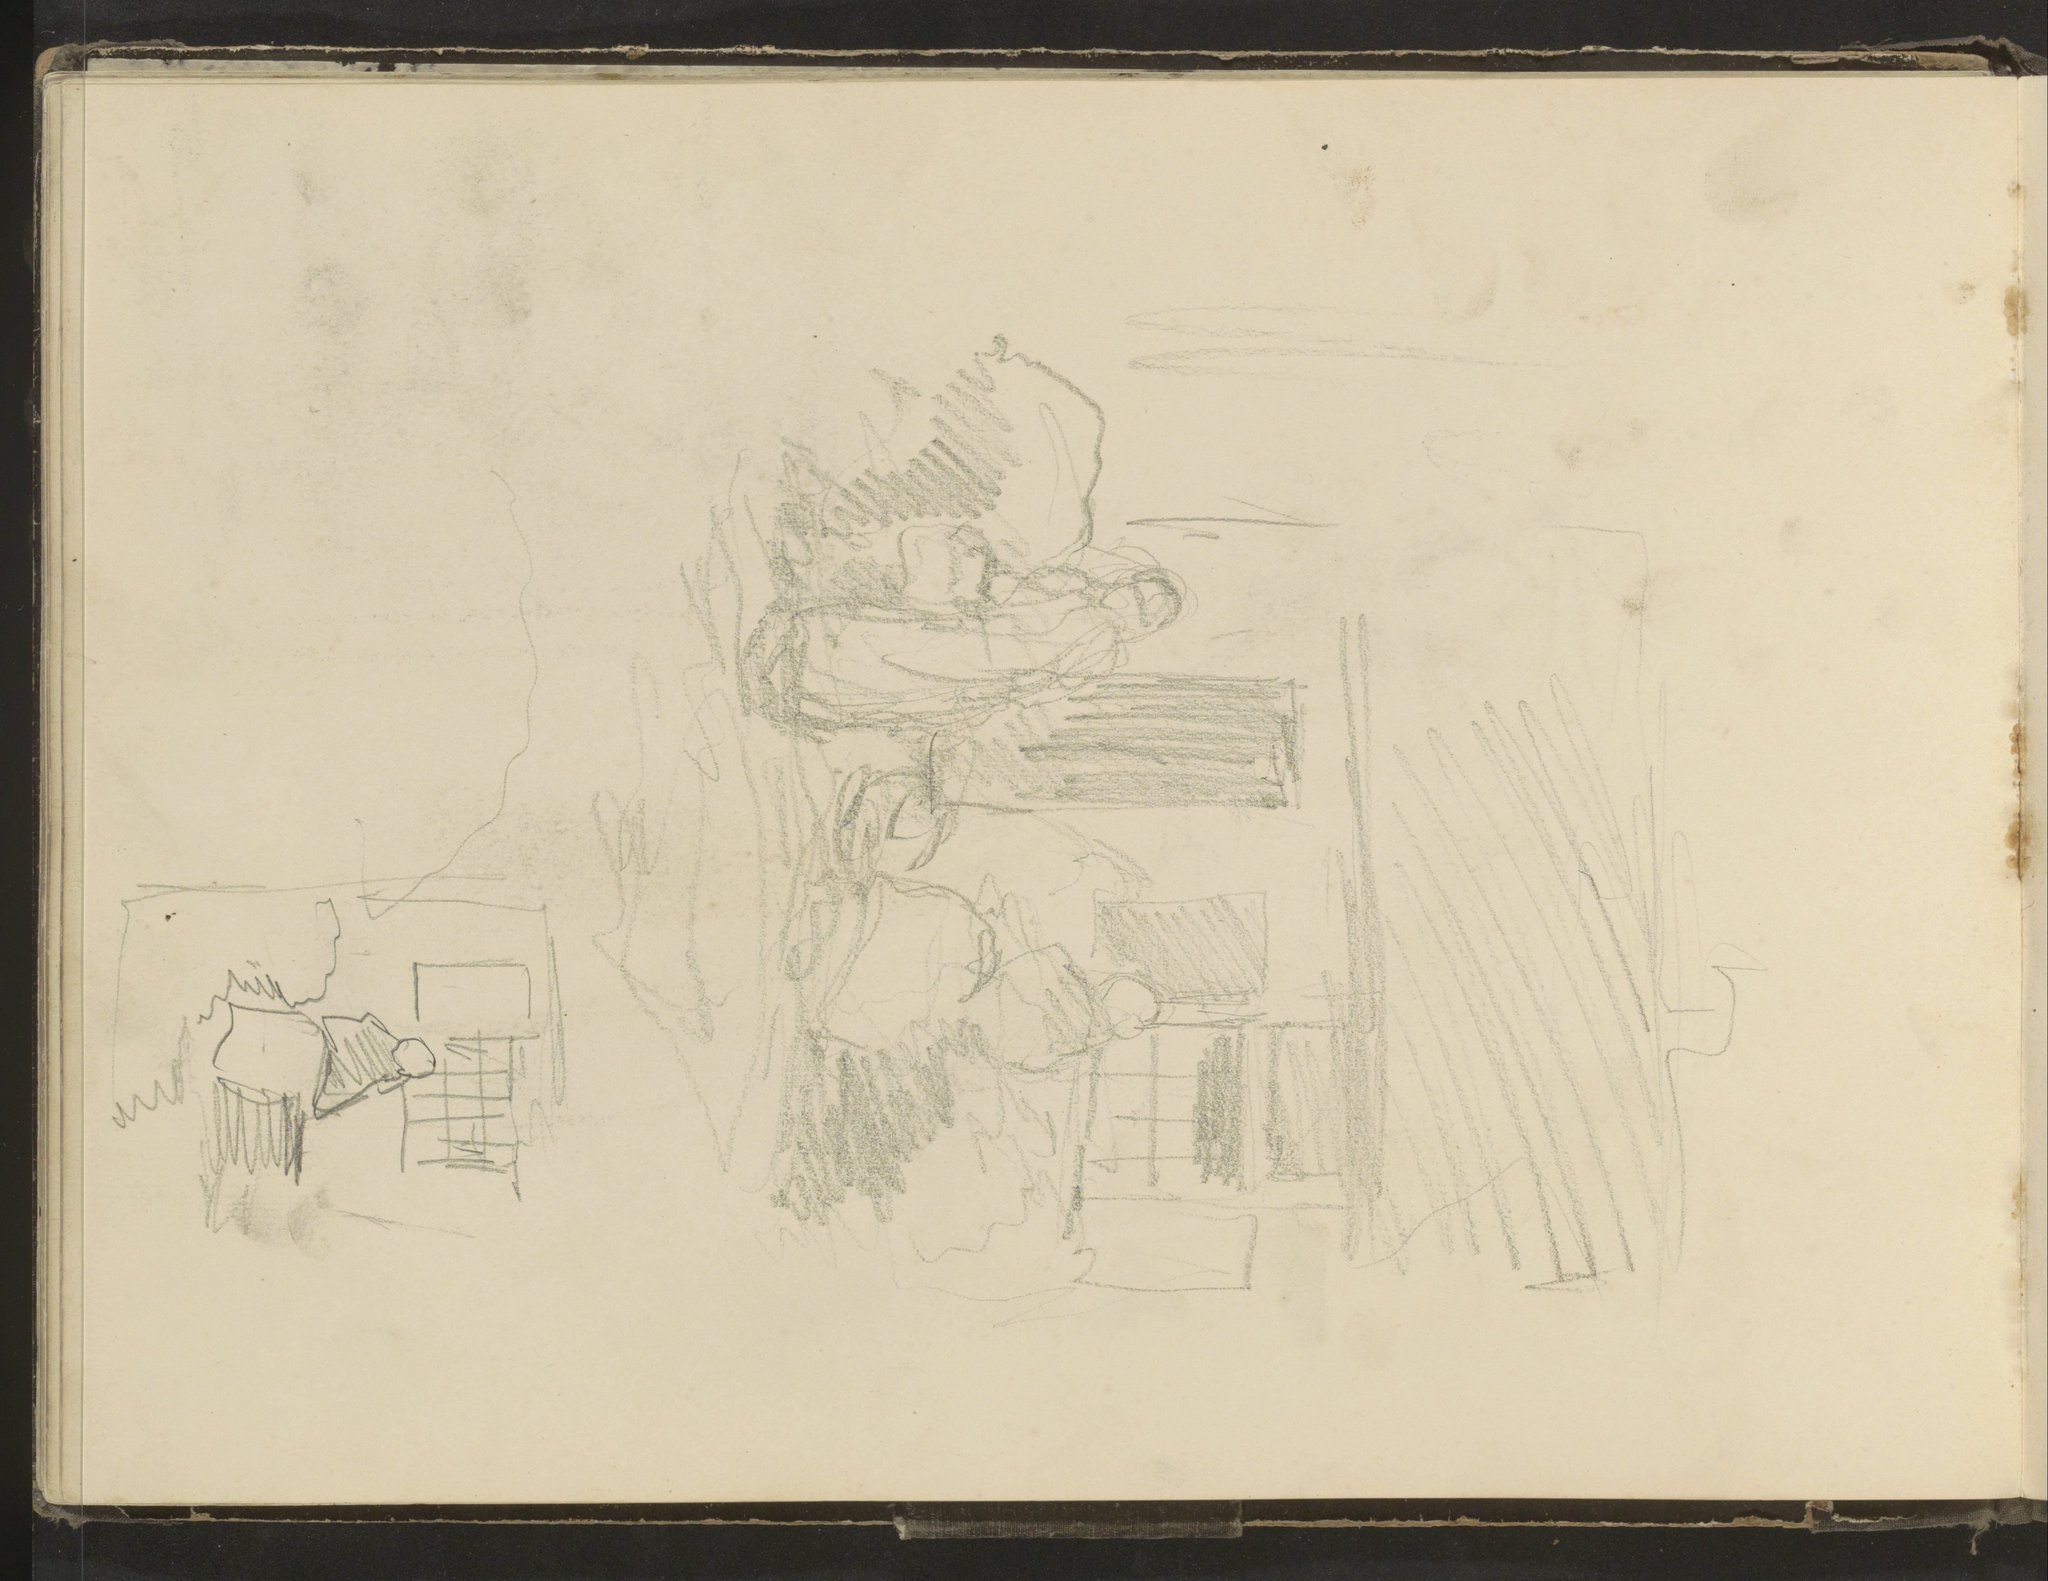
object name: sketchbook leaf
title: Figuren voor een boerenwoning met opengeslagen luiken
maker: albert neuhuys (1844-1914)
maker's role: draughtsman, painter, print maker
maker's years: 1844-1914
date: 1854-1914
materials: paper, pencil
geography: laren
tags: anatomy (non-medical), window shutters, rural housing, e.g. country-house, villa, cottage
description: Blad 17 verso uit een schetsboek met 43 bladen.